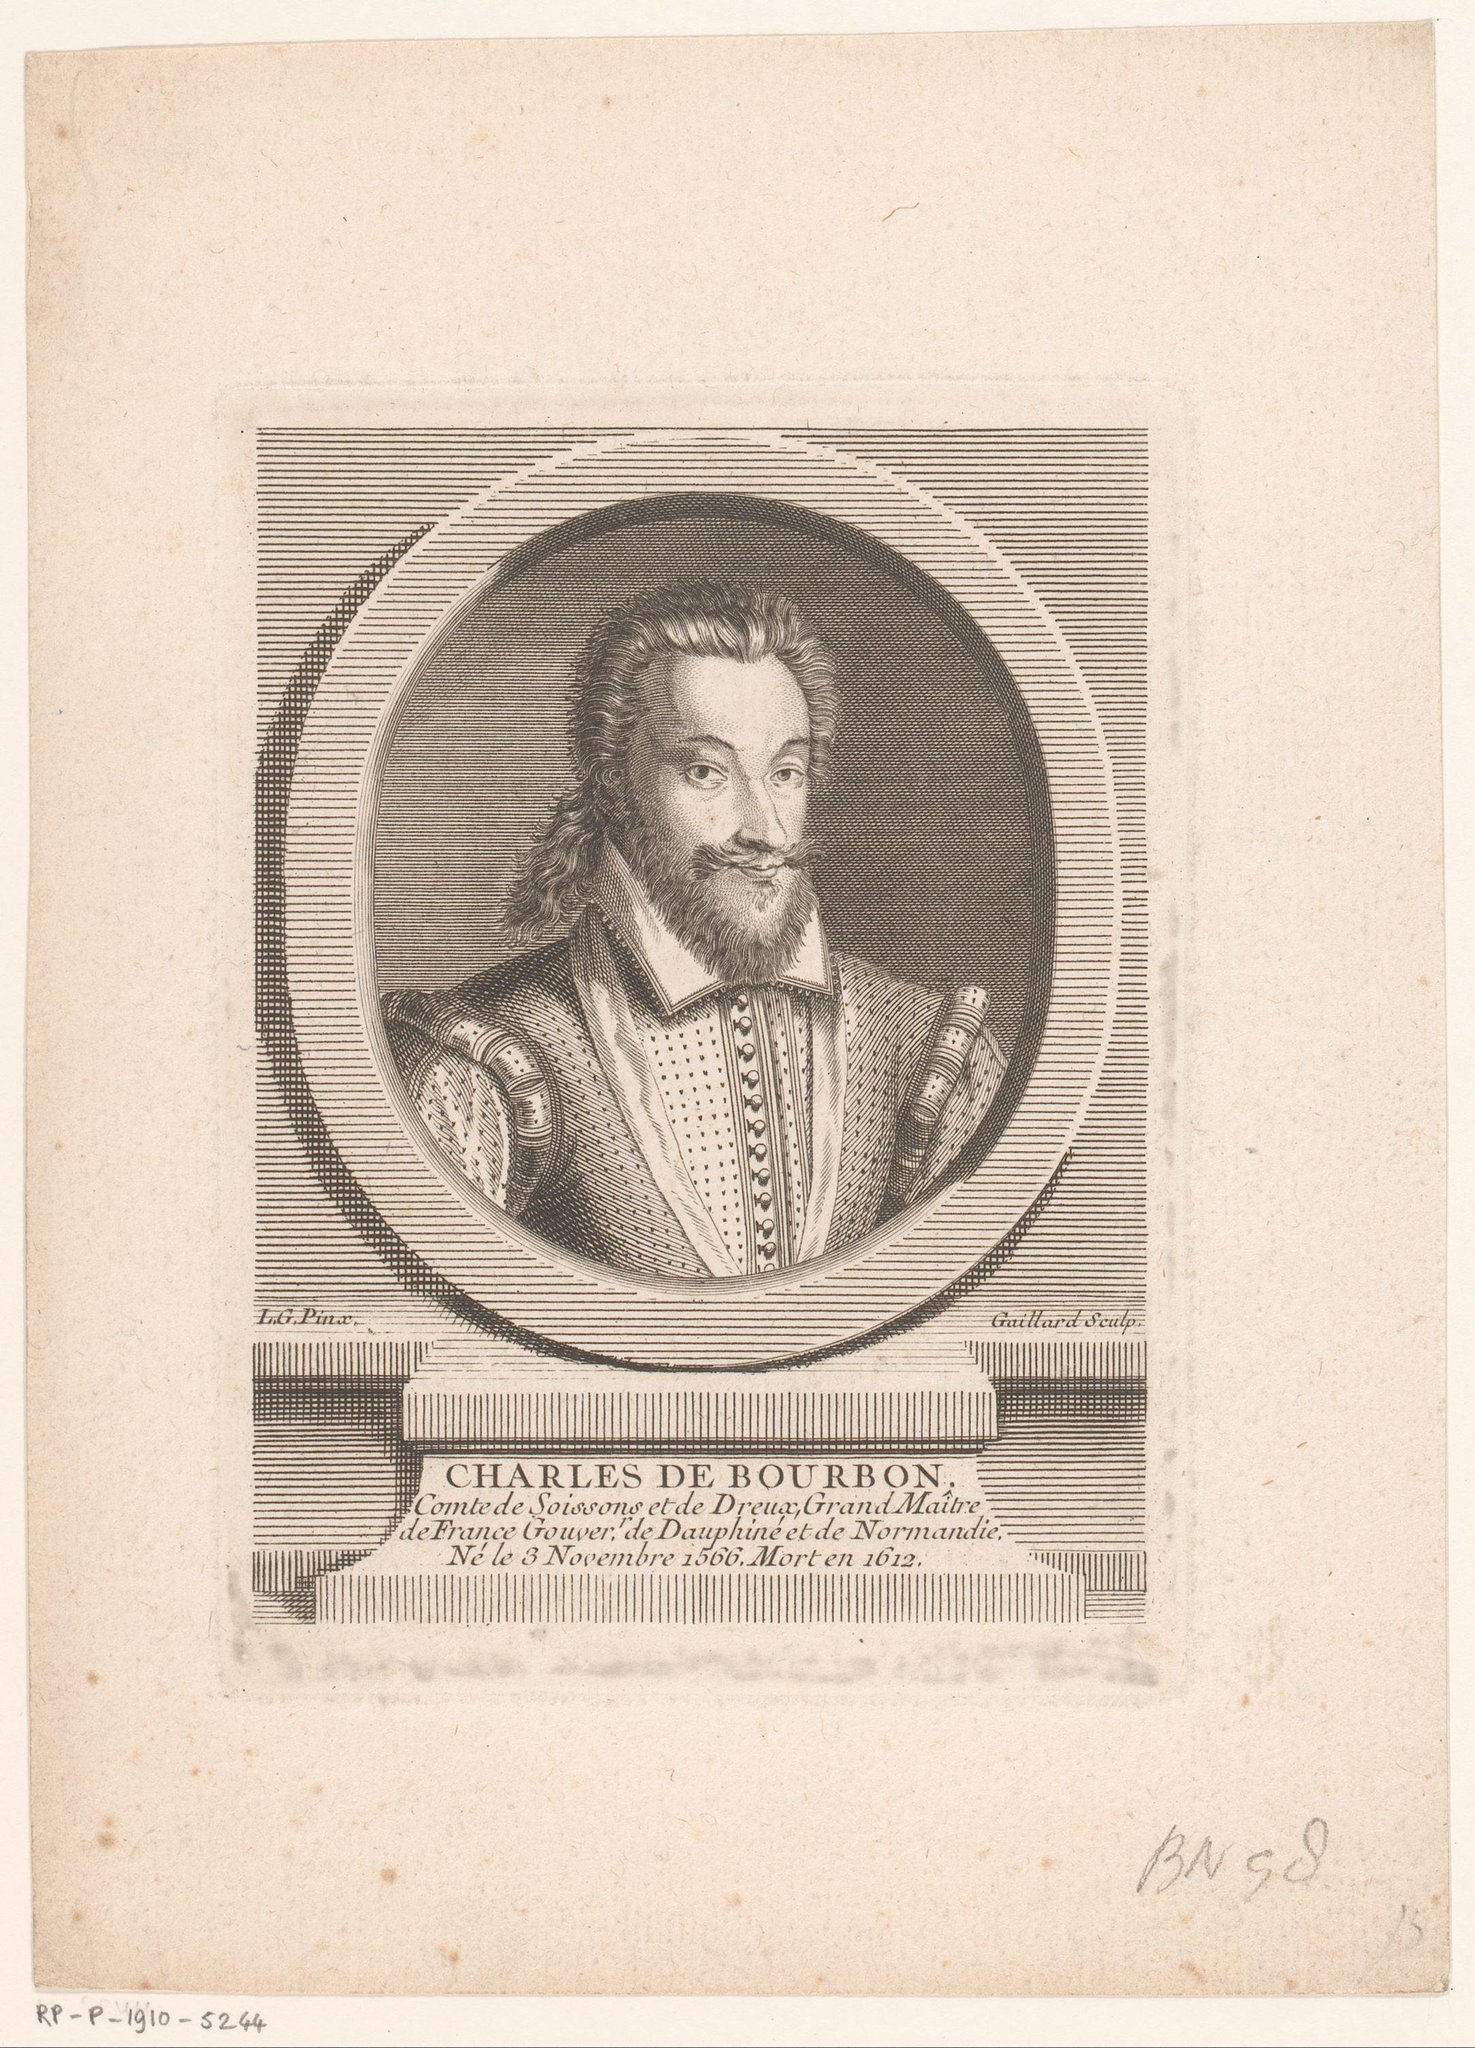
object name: print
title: Portret van Charles de Bourbon, graaf van Soisson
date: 1755-1765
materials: paper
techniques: engraving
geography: paris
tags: earl, historical persons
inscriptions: collector's mark: Lugt 2228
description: Mogelijk prent uit: Dreux du Radier, Jean-François. L'Europe illustré, contenant l'histoire abregée des souverains, des princes, des prélats, des ministres, (...) en Europe: dans le XVe. siècle compris, jusqu'à présent. Parijs: Michel Odieuvre en André-François Le Breton, 1755-1765, dl. 3.